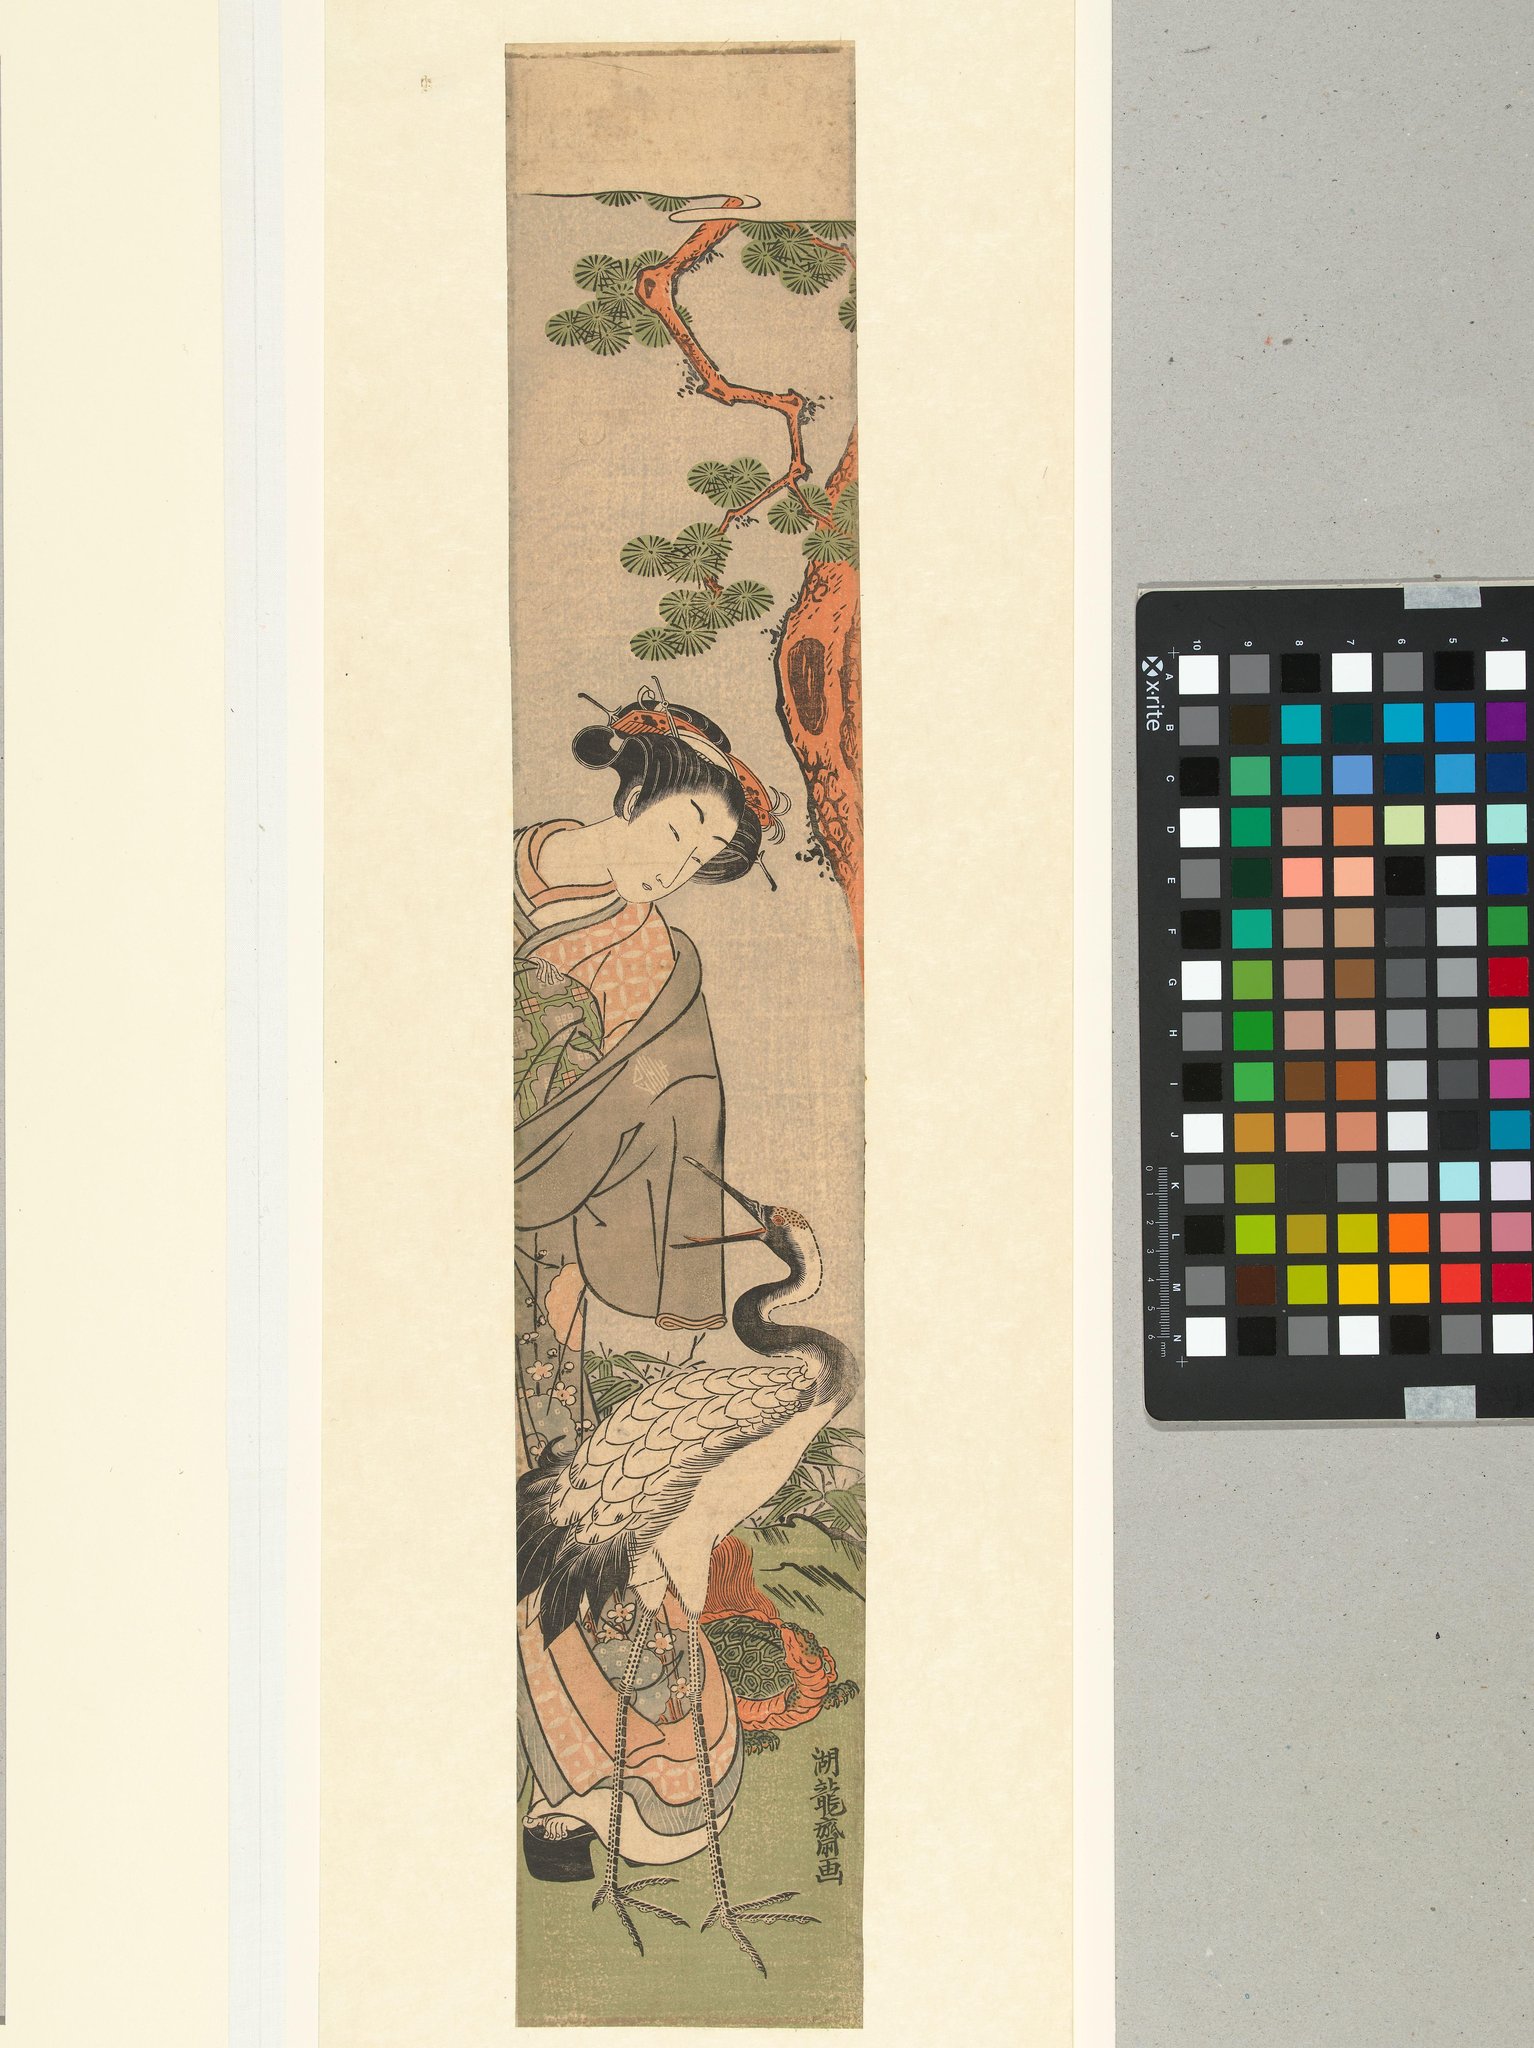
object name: print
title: Courtisane, kraanvogel en schildpad bij pijnboom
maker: isoda kôryûsai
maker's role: print maker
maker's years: 1735-1790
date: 1770-1780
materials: paper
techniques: woodcut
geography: japan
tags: shore-birds and wading-birds: crane, tortoises, turtles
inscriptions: collector's mark: Lugt 2228